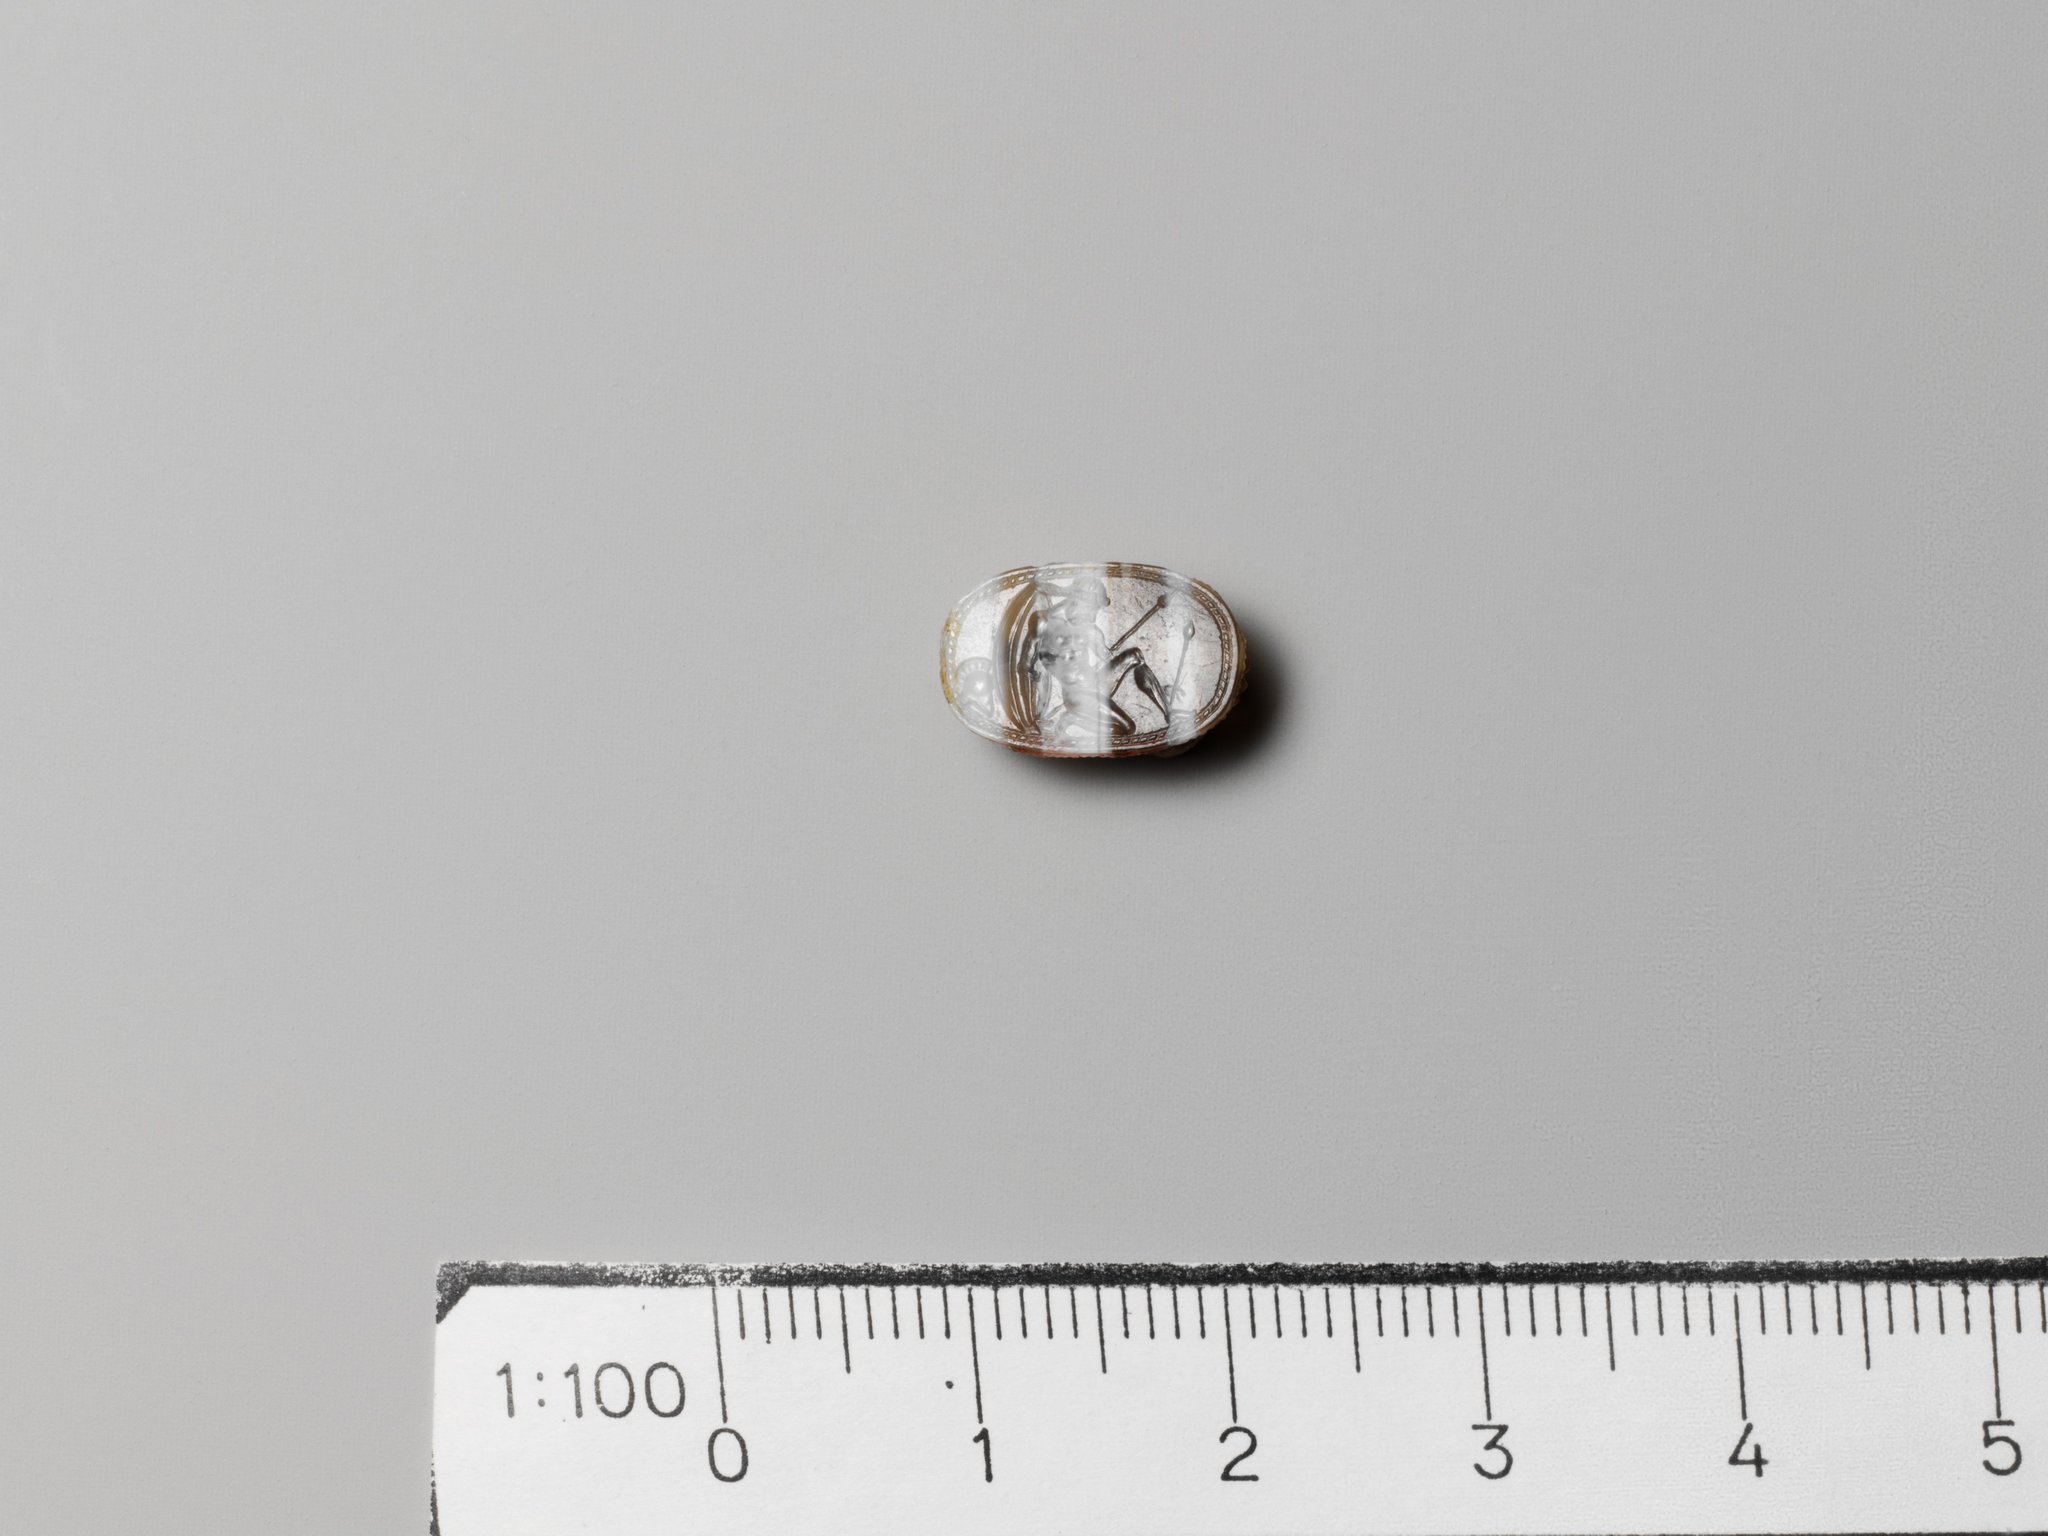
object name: scarab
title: Agate scarab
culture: etruscan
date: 400-368 BCE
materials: stone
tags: arrows,male nudes,achilles